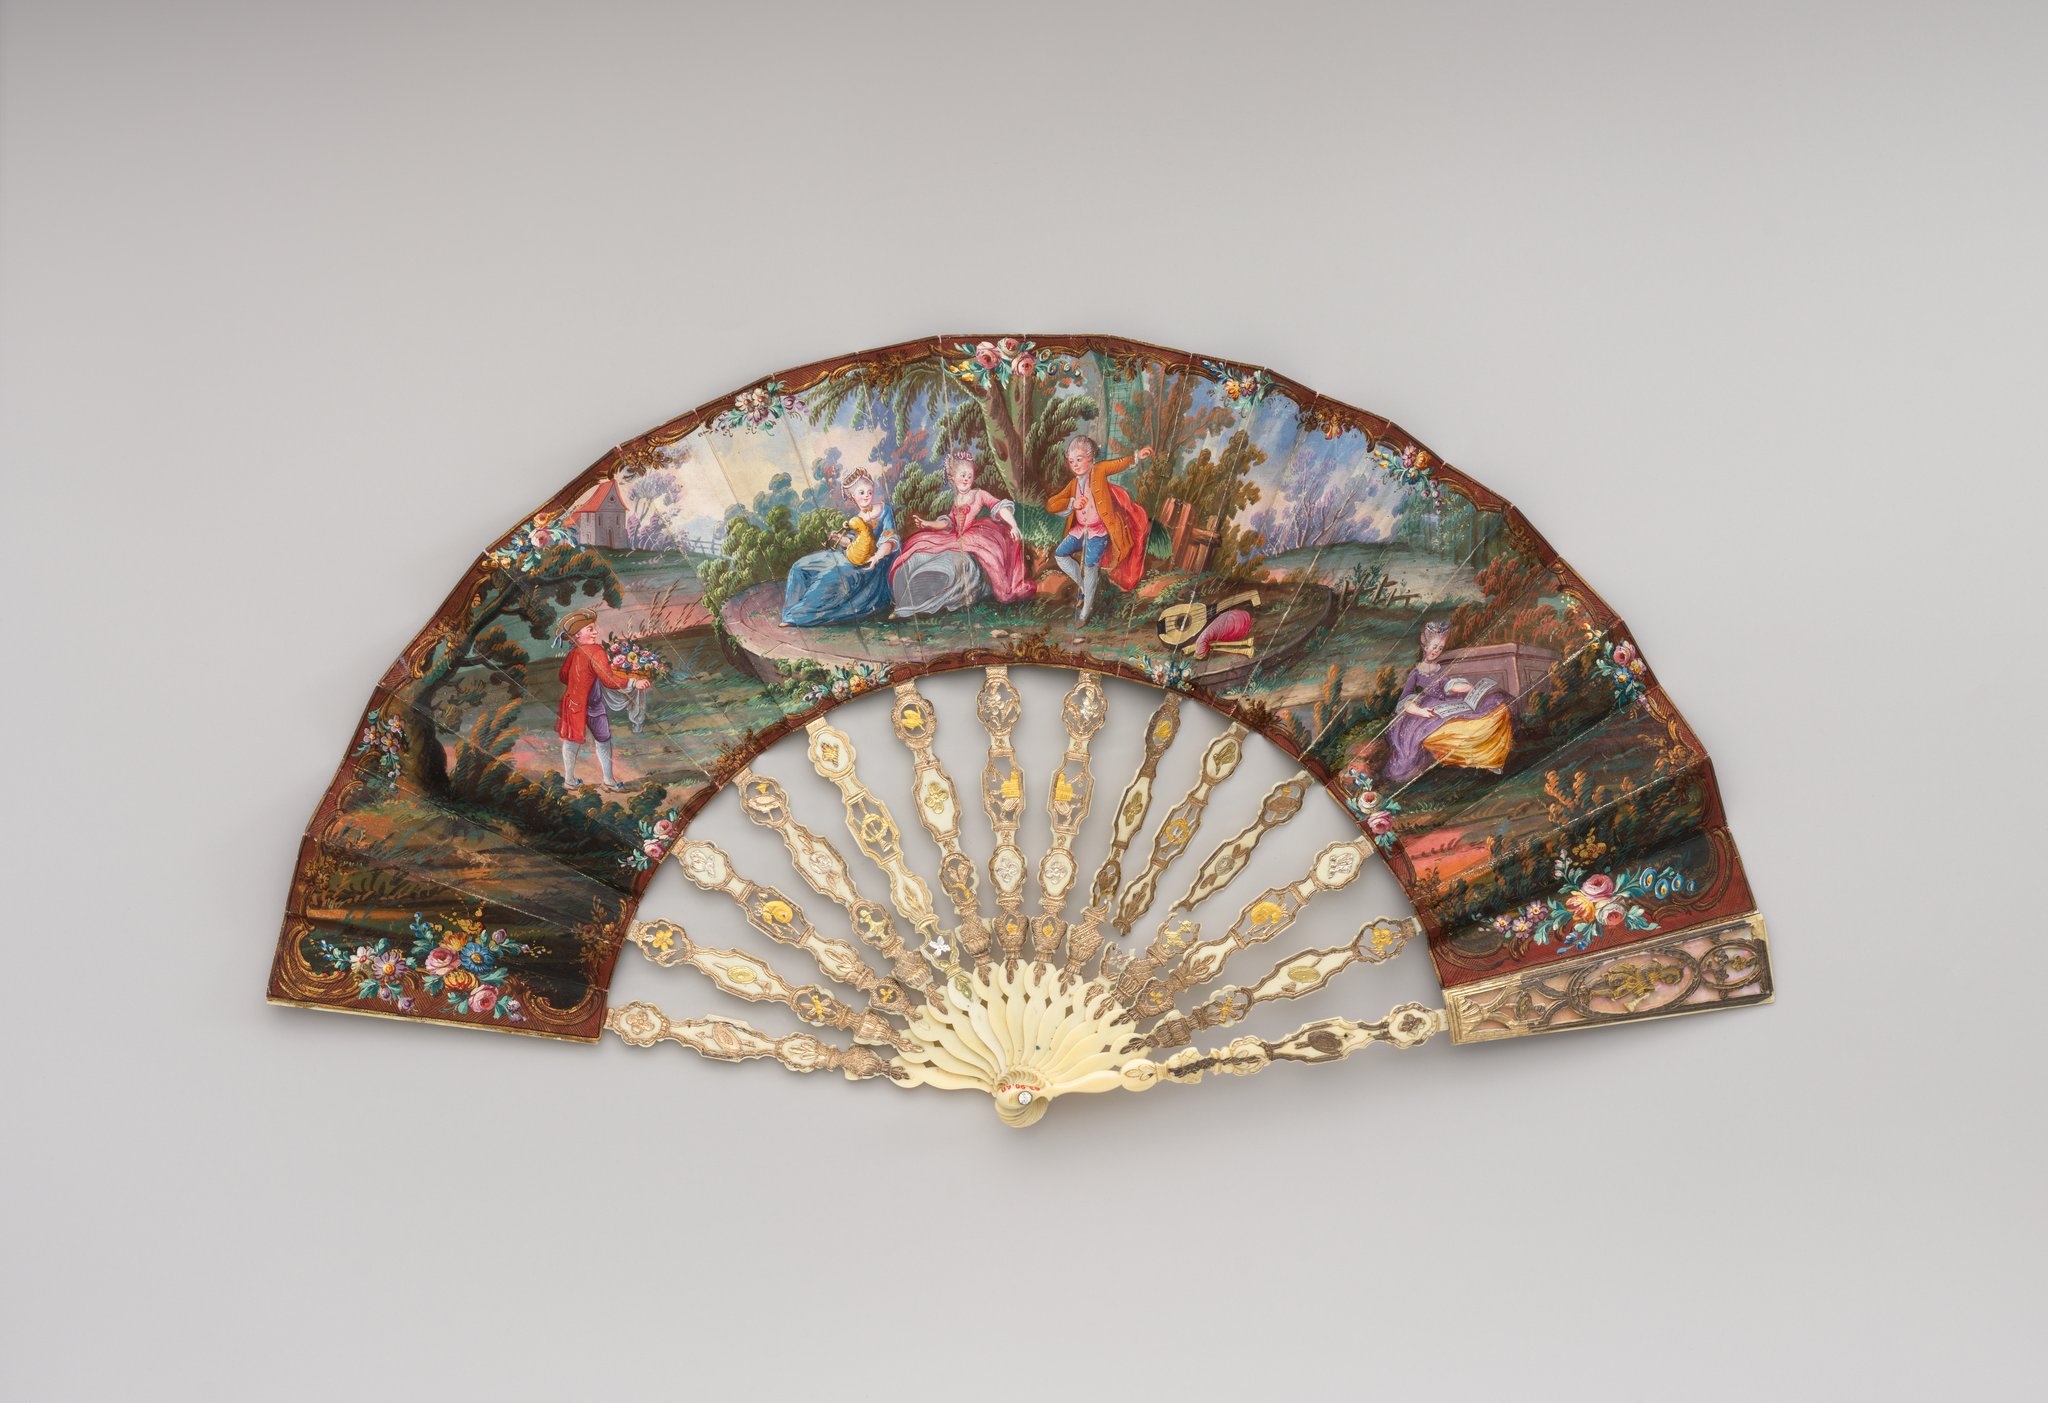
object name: fan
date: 1701-1800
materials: glass, gold, ivory, mother of pearl, paint, paper, silver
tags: men,women,bagpipes,lutes